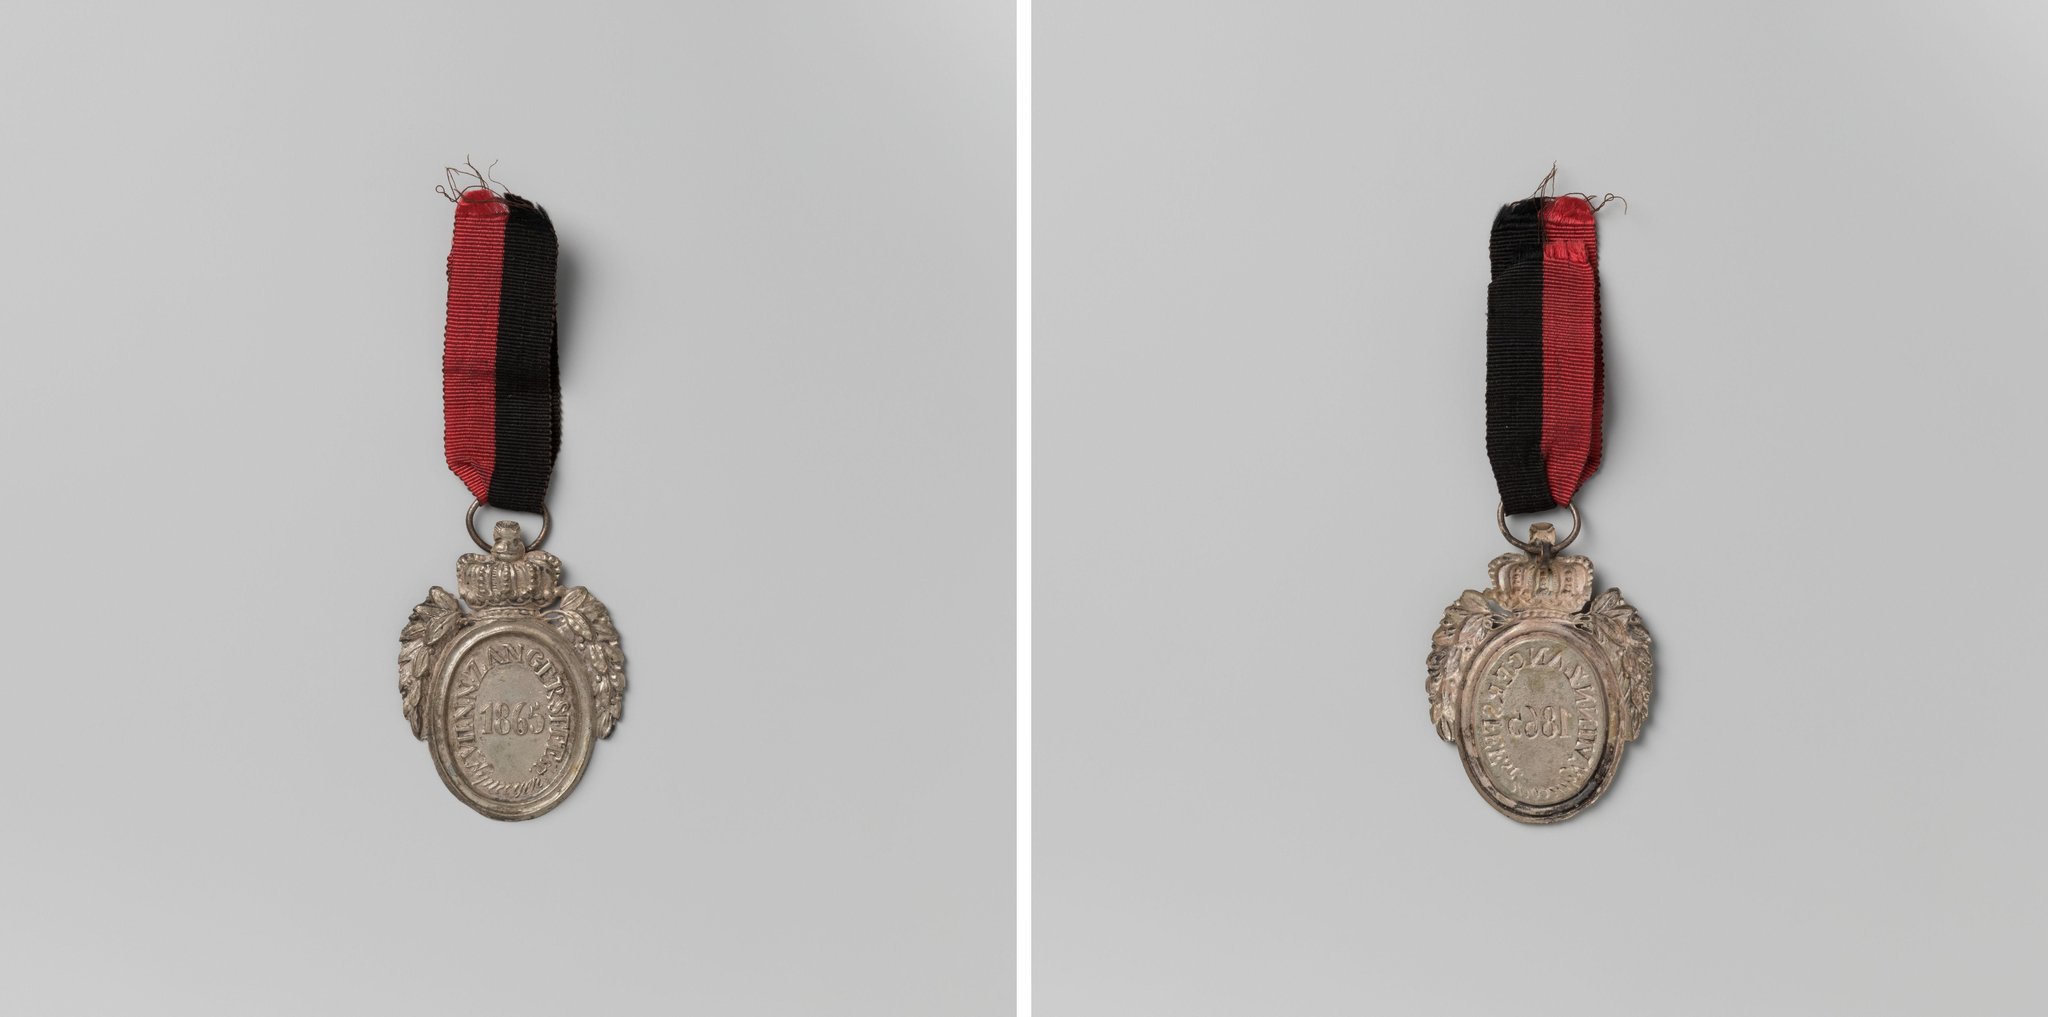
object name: insignia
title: Zevende Nederlandsch nationaal zangersfeest te Nijmegen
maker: Anonymous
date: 1865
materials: copper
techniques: silvering, striking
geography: nijmegen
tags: nijmegen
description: eenzijdig insigne, opgebouwd uit ovaal medaillon onder kroon, waarvan lauwertakken afhangen; op medaillon: jaartal binnen omschrift